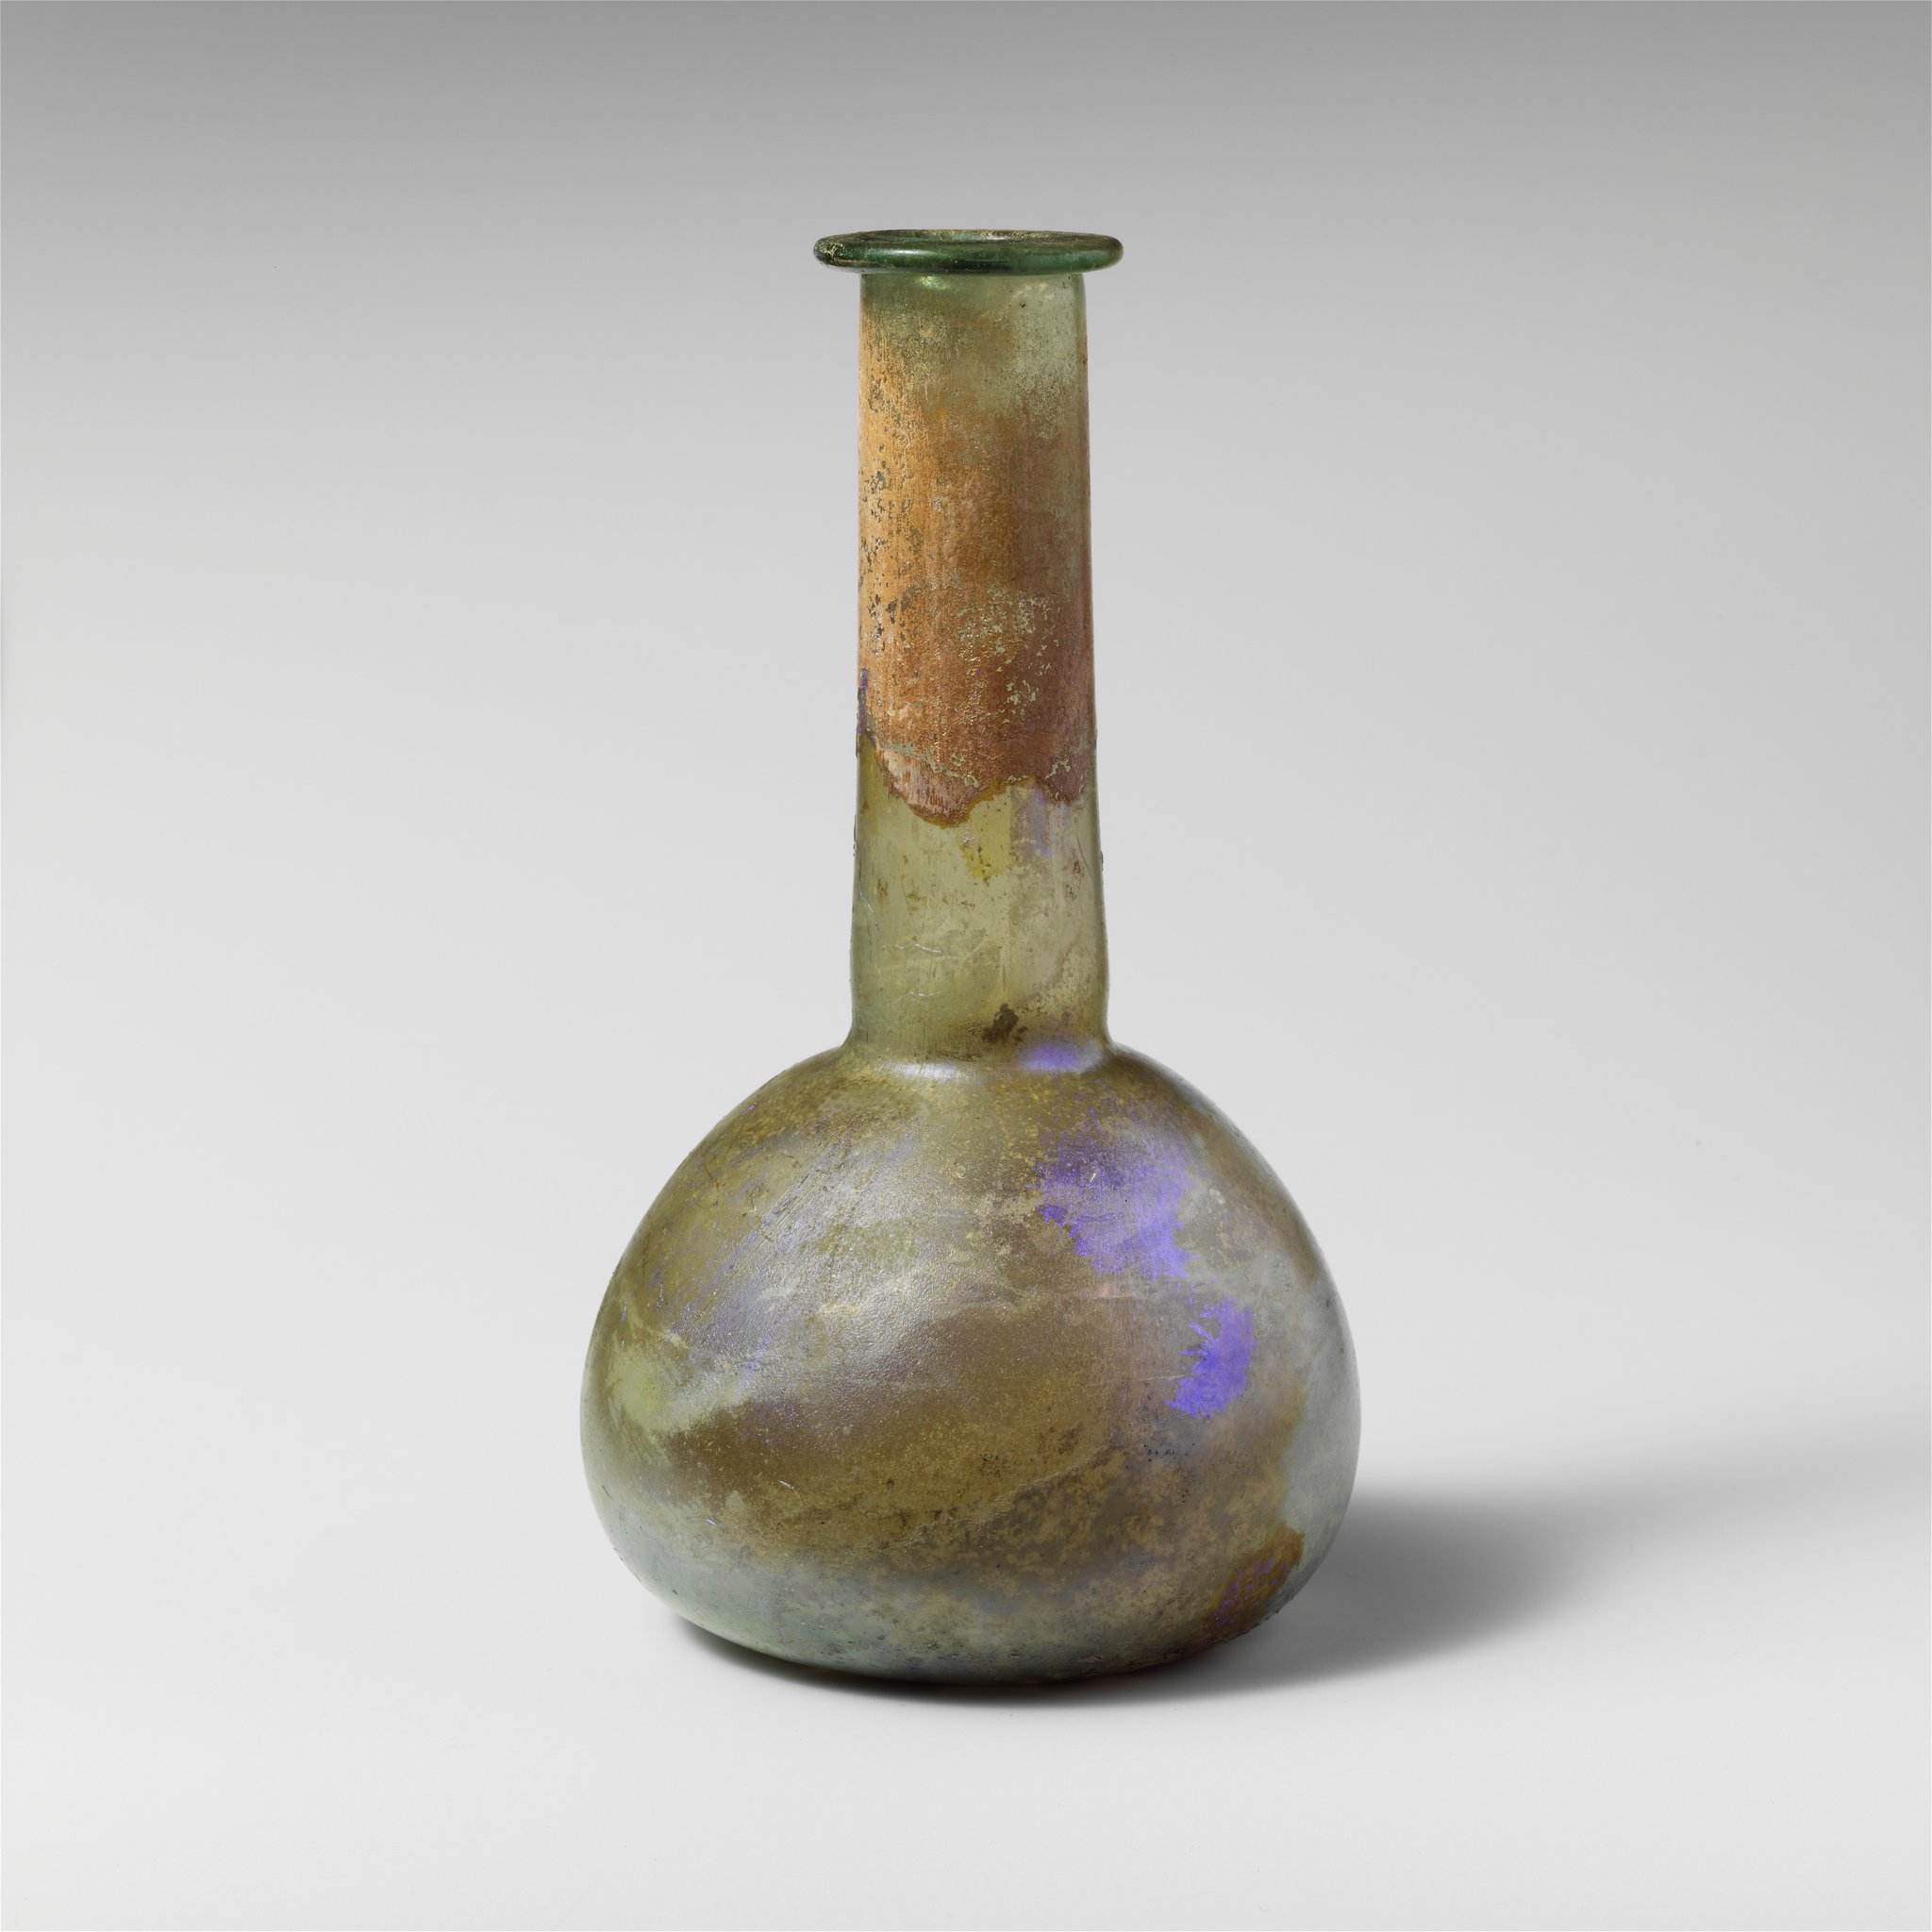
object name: perfume bottle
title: Glass perfume bottle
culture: roman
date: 101-300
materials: glass